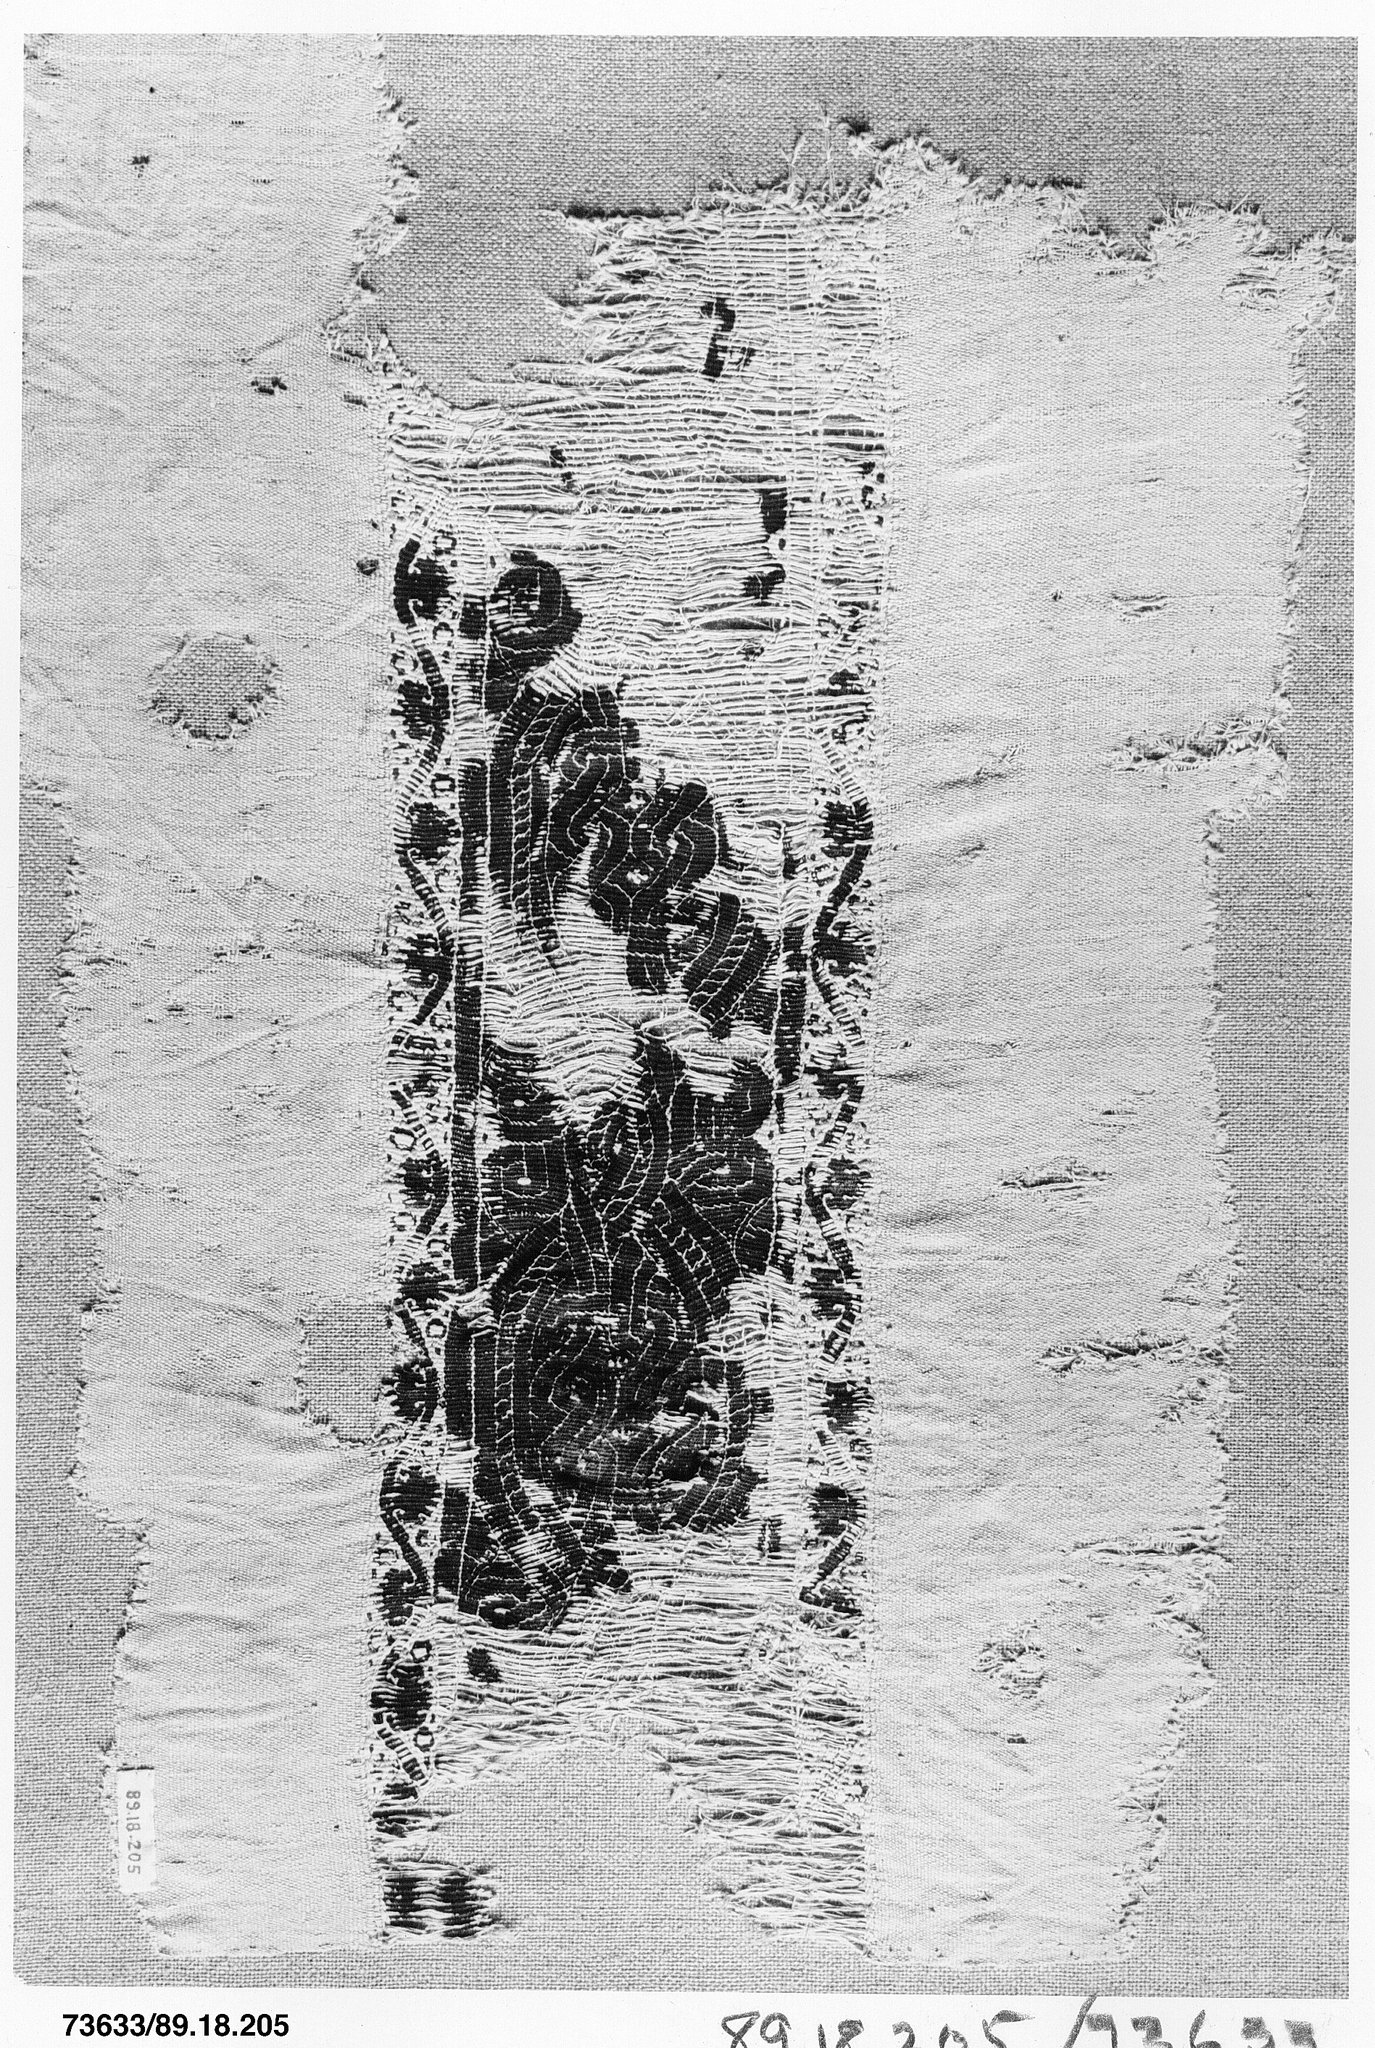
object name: textile fragment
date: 301-400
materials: linen, wool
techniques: weave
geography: egypt